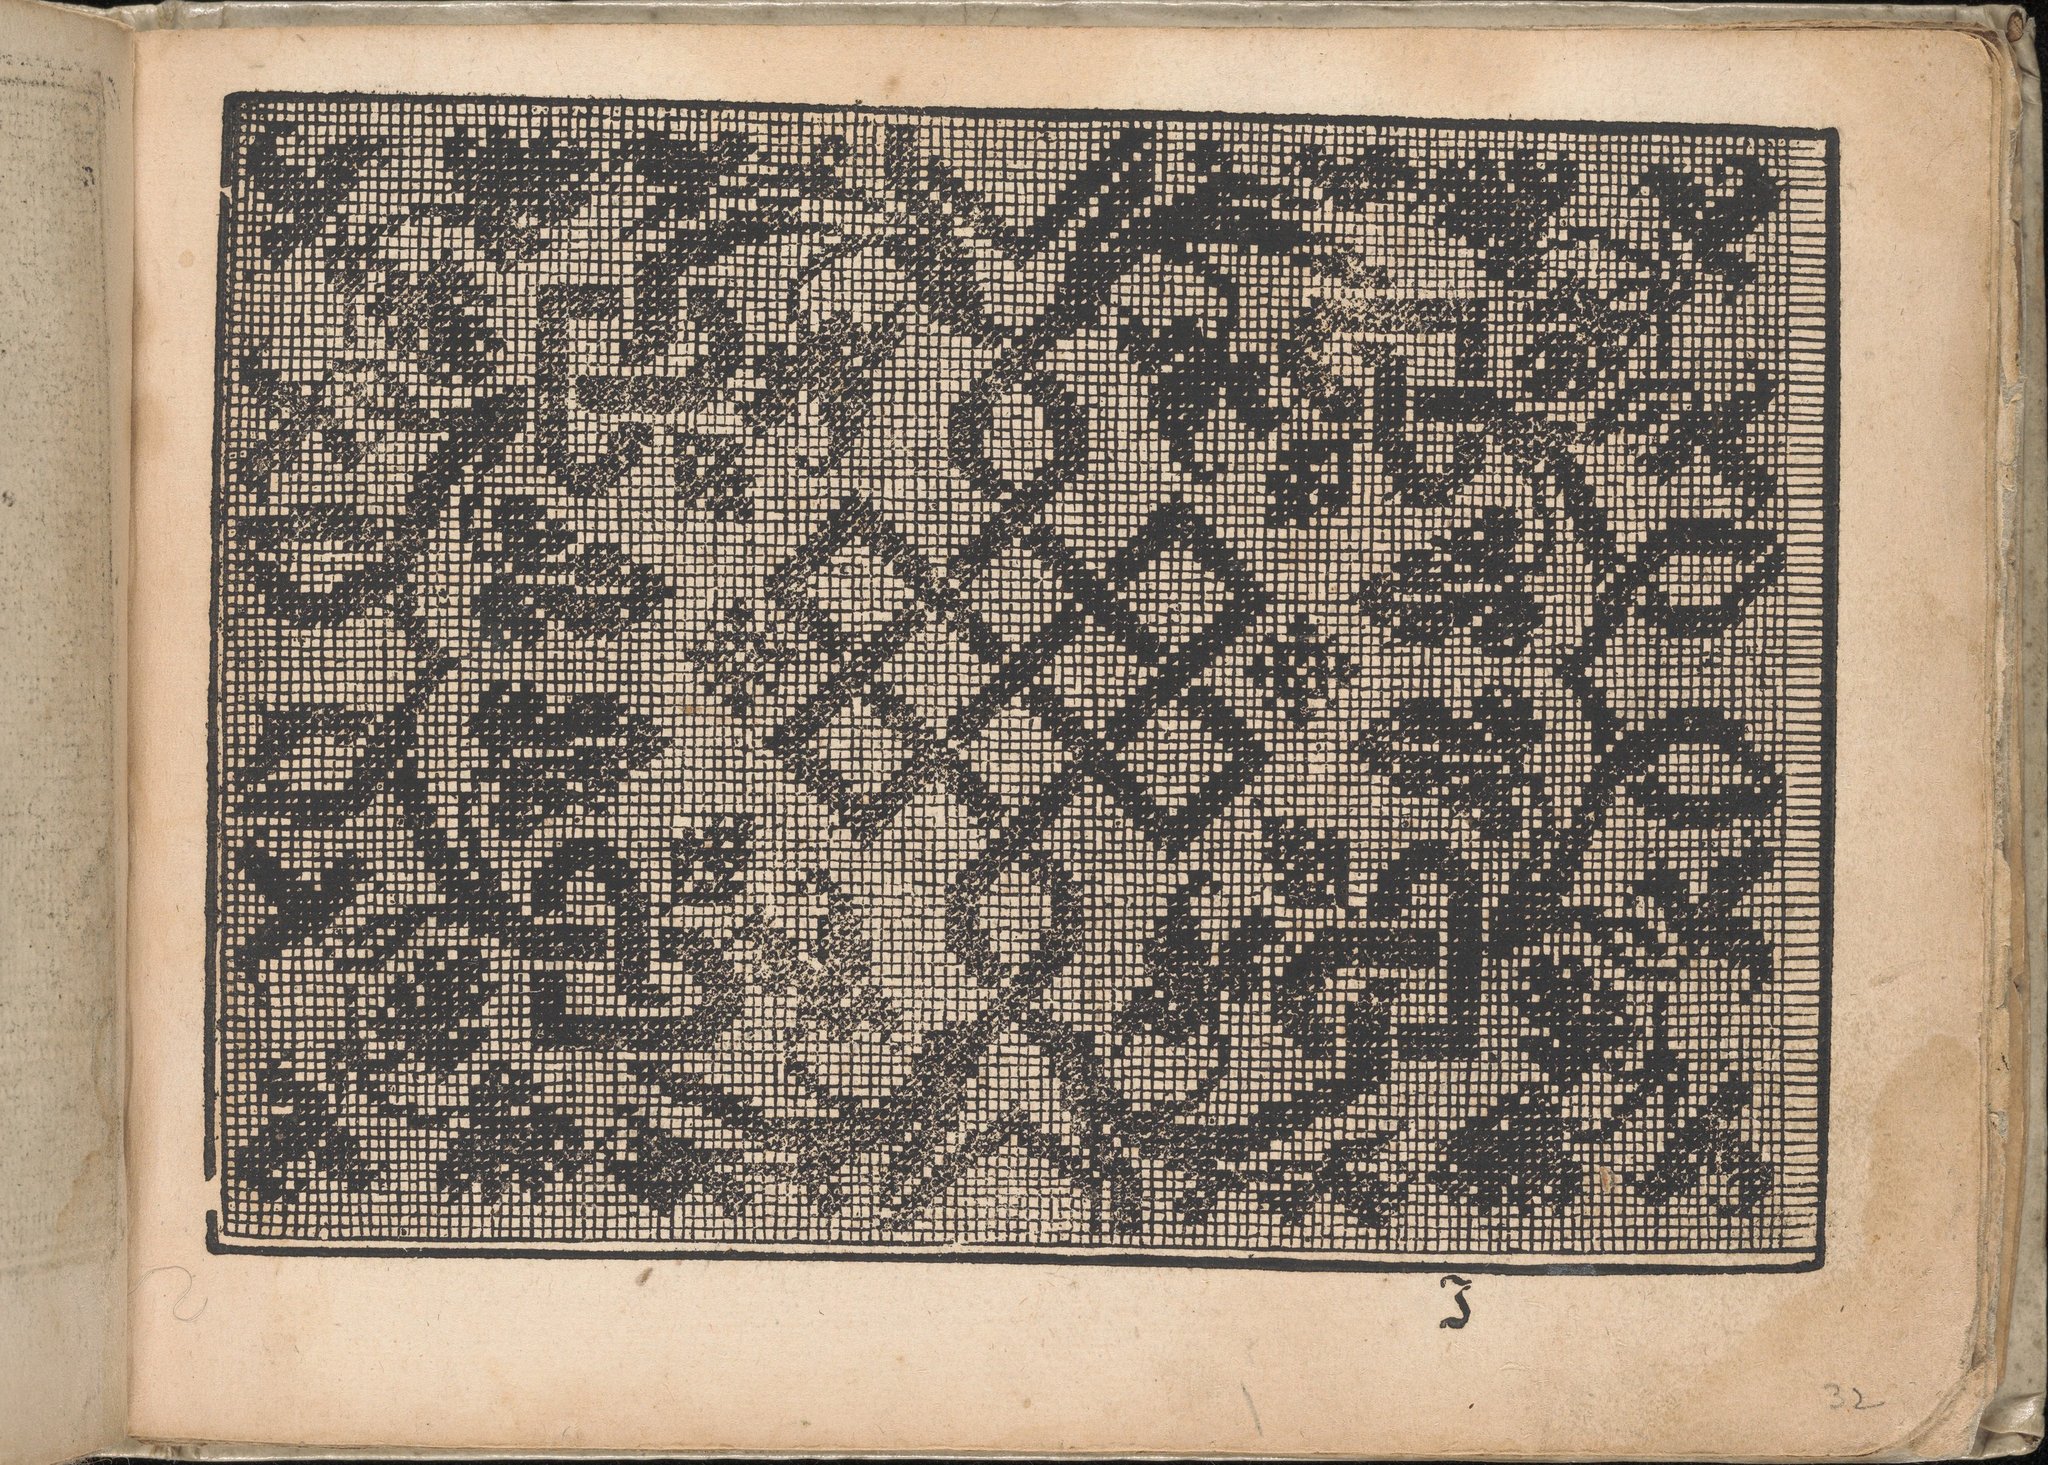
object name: book print ornament architecture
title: Neu künstlich Modelbuch (page 32r)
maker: bernhard jobin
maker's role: publisher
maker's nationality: swiss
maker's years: 1535-1597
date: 1598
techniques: woodcut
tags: ornament